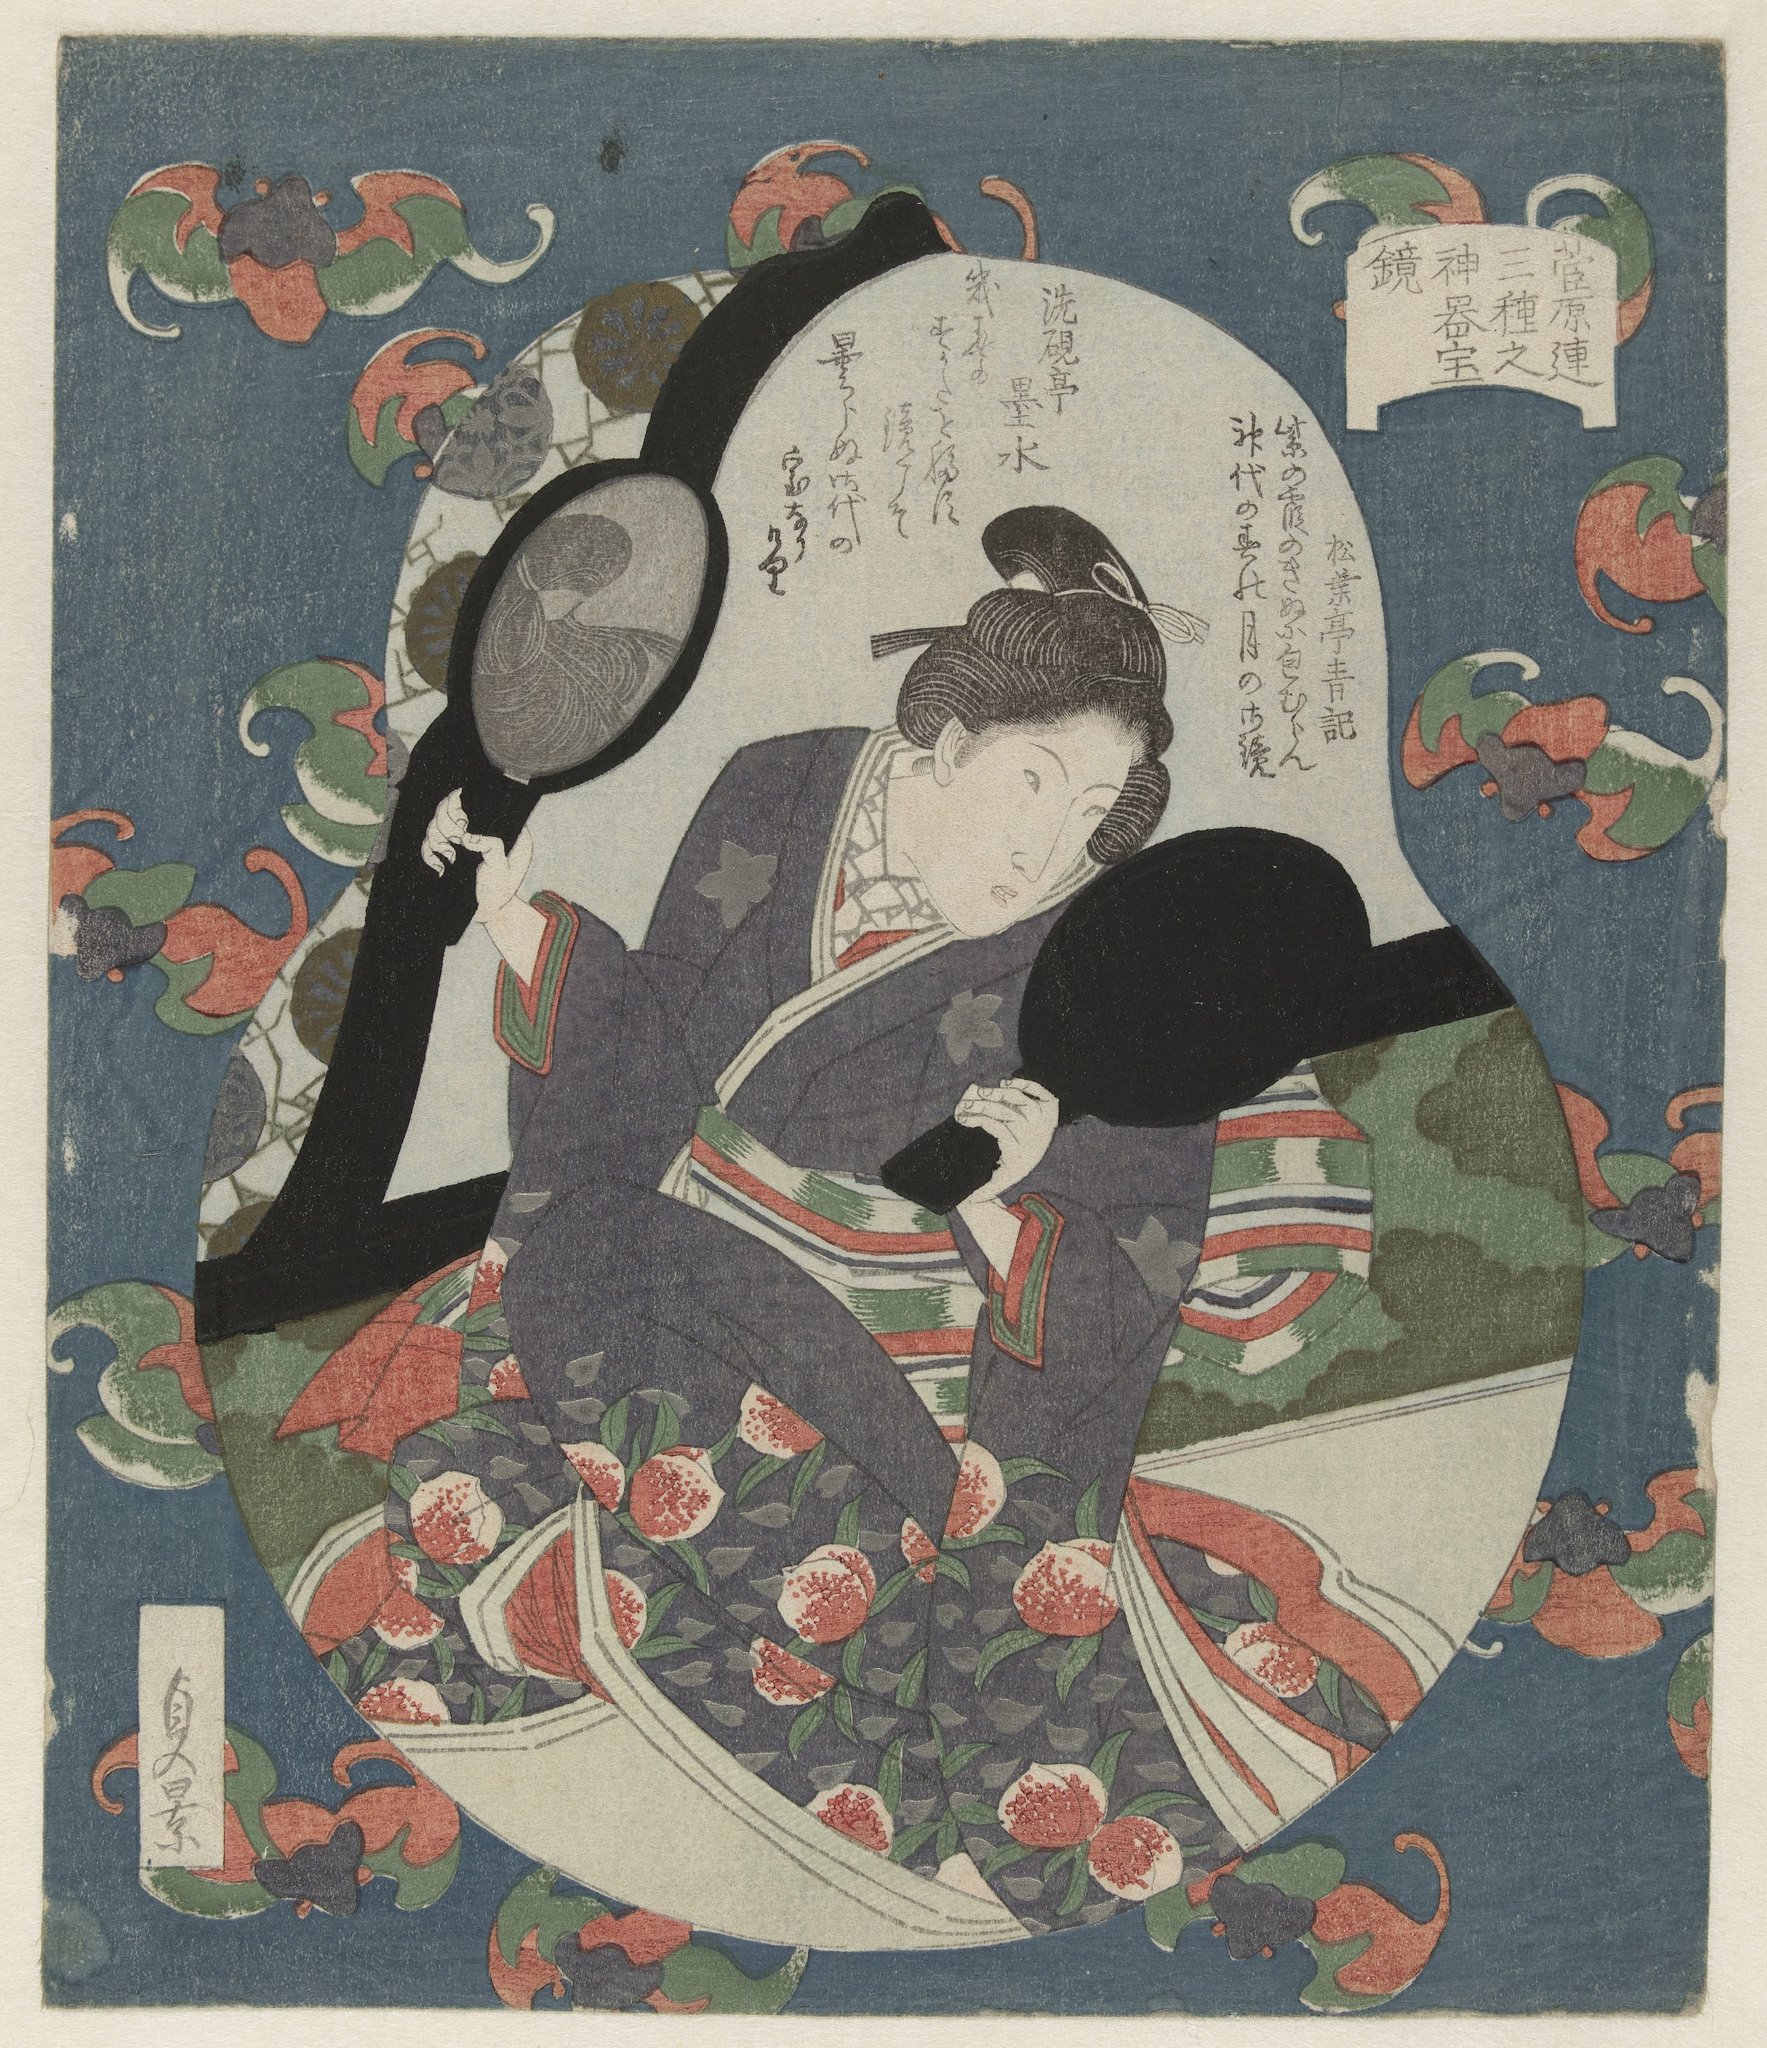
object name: print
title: Vrouw bekijkt haar kapsel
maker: utagawa sadakage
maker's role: print maker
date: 1830-1835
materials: gold powder, paper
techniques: blind stamped, woodcut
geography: tokyo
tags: mirror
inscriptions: collector's mark, verso, stamped: Lugt 2228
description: Een surimono is een luxe uitgevoerde prent waarop beeld met één of meerdere gedichten gecombineerd is. Bij het drukken van een surimono werd vaak gebruik gemaakt van dikker papier, blinddruk en metaal pigmenten, zoals koper- en zilverpoeder. De prenten werden vaak in opdracht van dichters gemaakt en als exclusief geschenk aan vrienden en relaties gegeven.